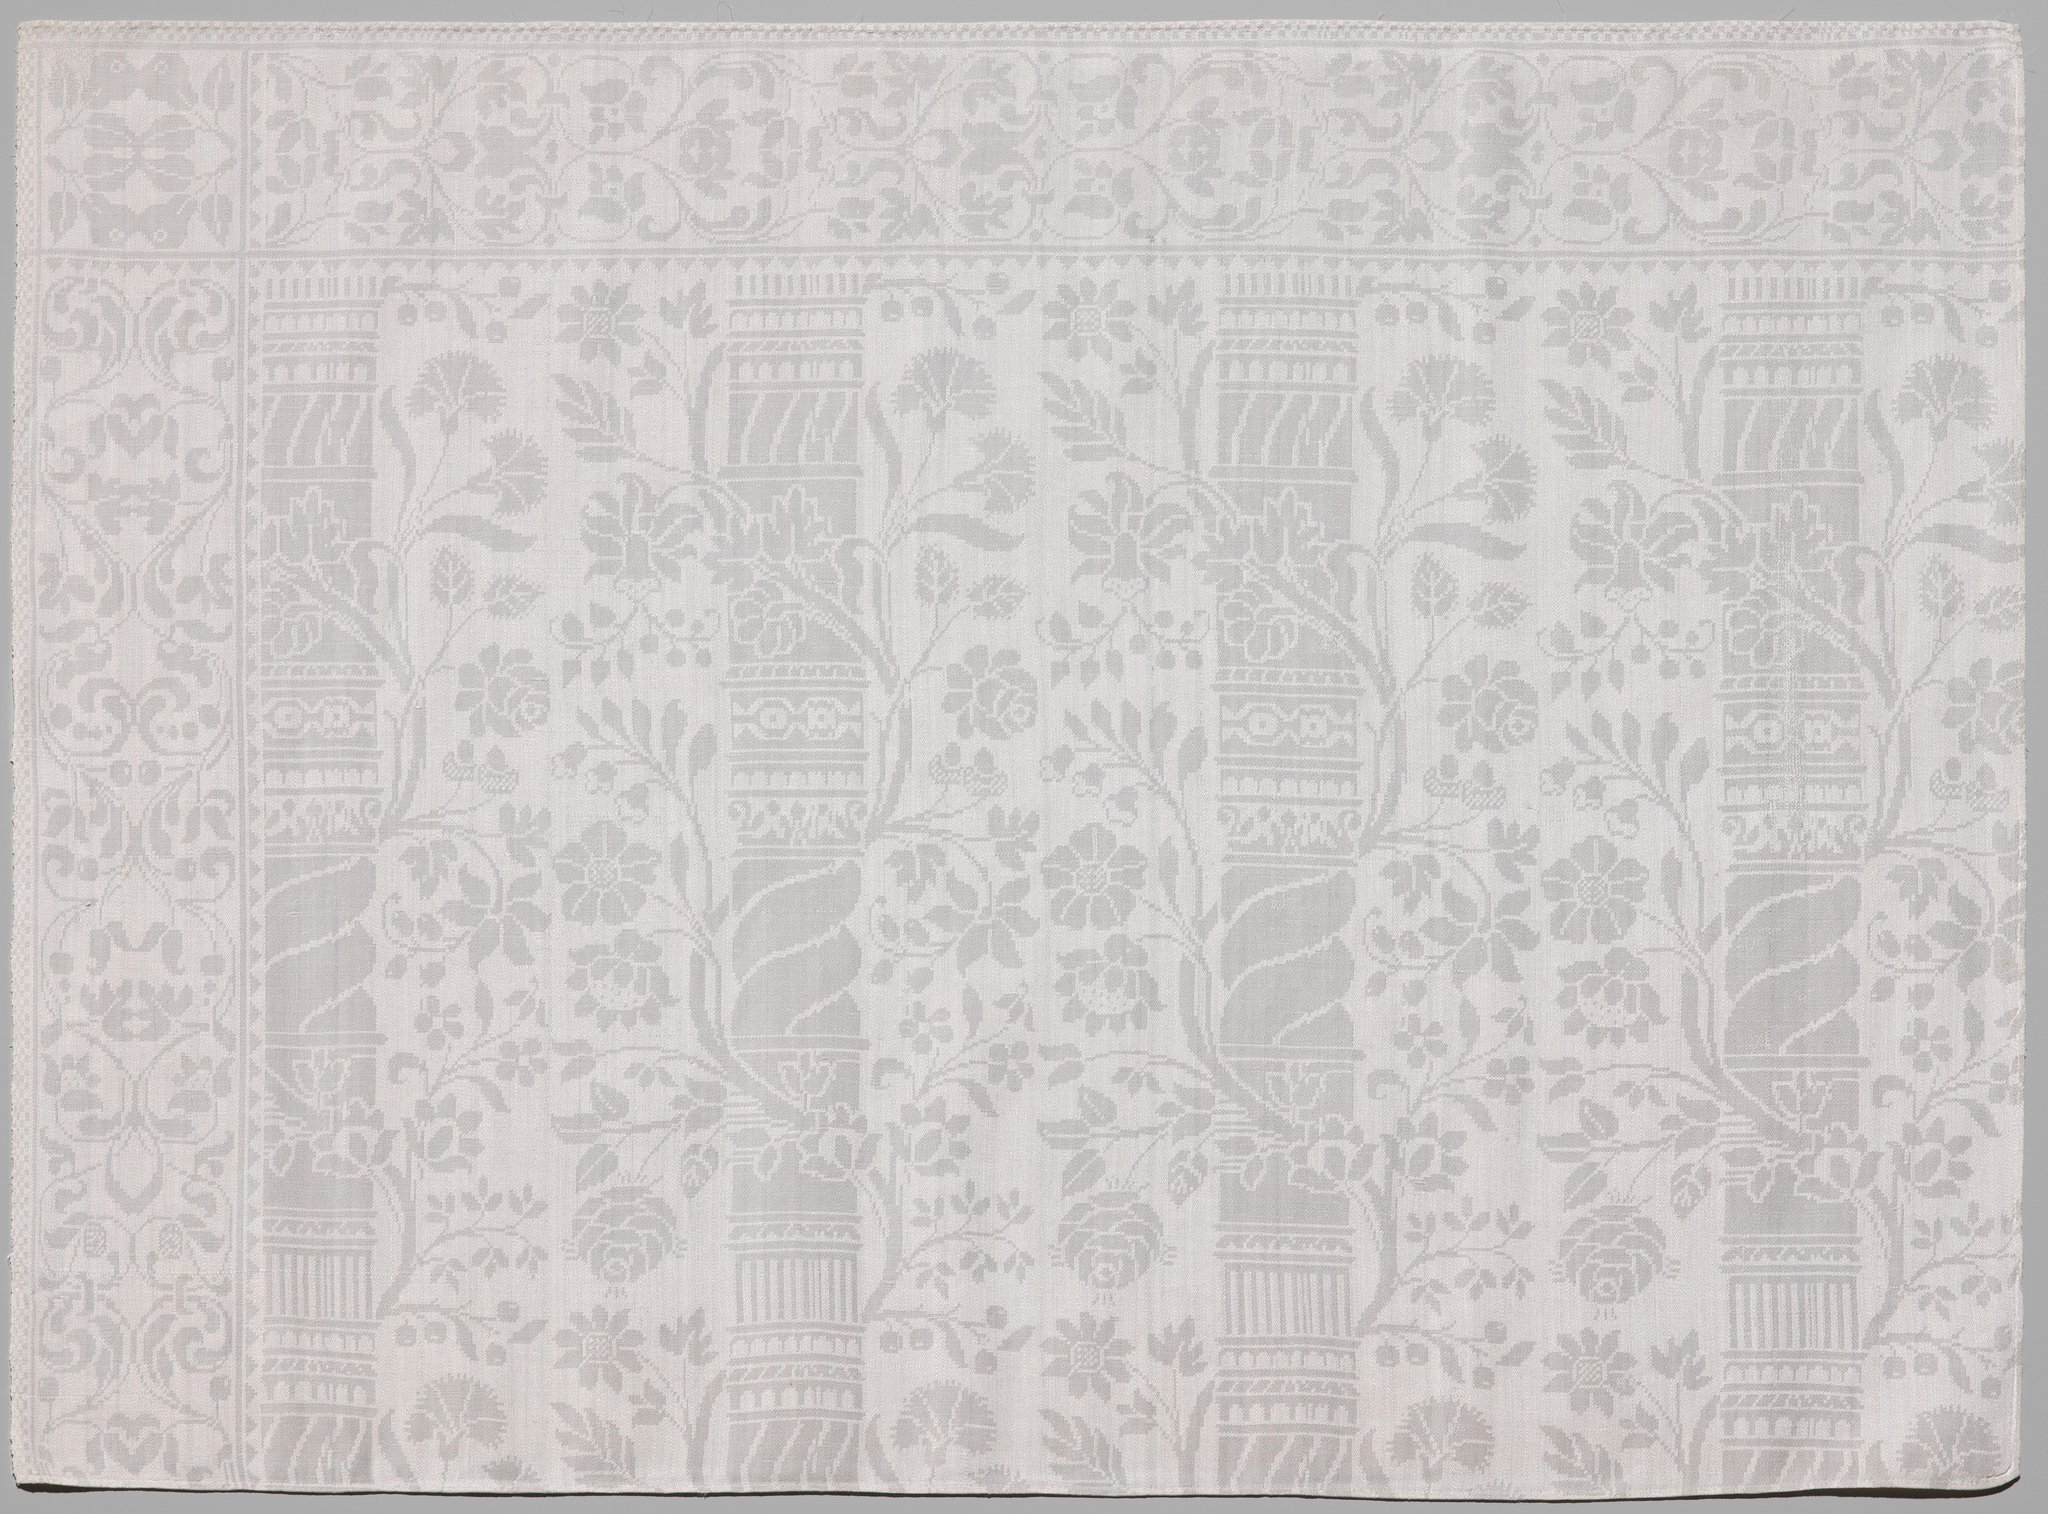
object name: tablecloth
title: Fragment van een tafellaken van linnendamast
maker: Anonymous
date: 1710-1715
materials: linen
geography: northern netherlands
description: Wit linnendamasten tafellaken met een bizar patroon met zuilen, merk GOVB.